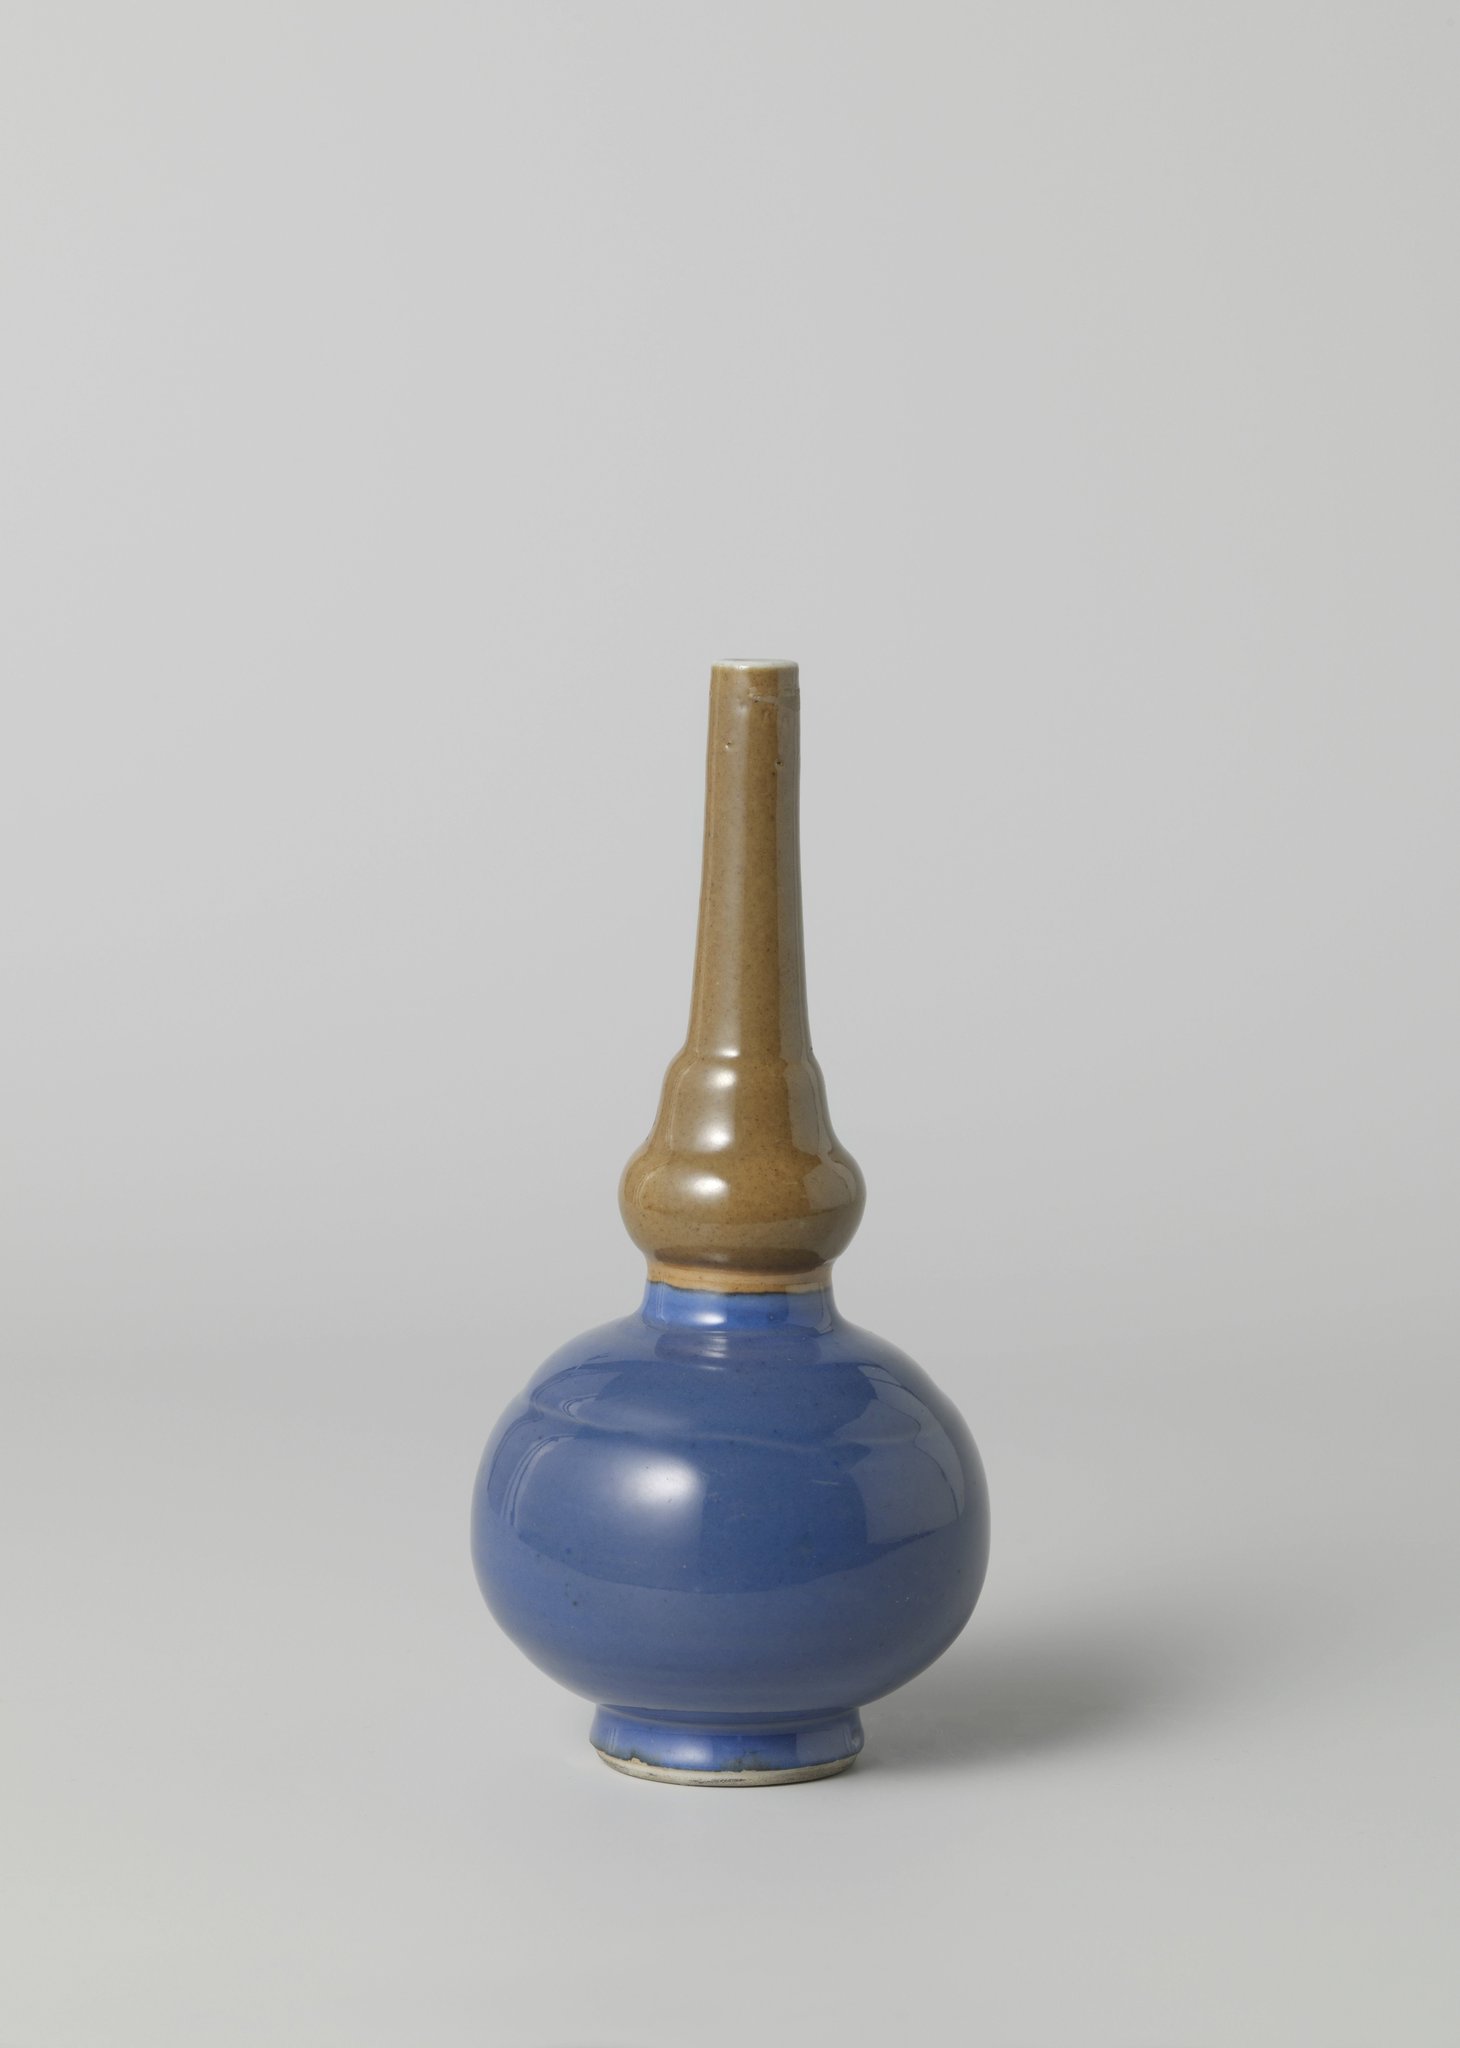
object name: sprinkler flask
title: Rosewater sprinkler or bottle with powder blue and light brown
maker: Anonymous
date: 1700-1724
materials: cobalt, glaze, paint, porcelain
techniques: firing, turning, vitrification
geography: china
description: Rozenwater druppelaar of puntfles van porselein met bolvormig lichaam met een horizontale, ingegrifte lijn en verdikkingen in de lange, smalle nek, bedekt met onderglazuur blauw en café-au-lait glazuur. Het lichaam is bedekt met bleu poudré (poederblauw); de nek is bedekt met een lichtbruin glazuur. Bleu poudré met monochroom bruin.